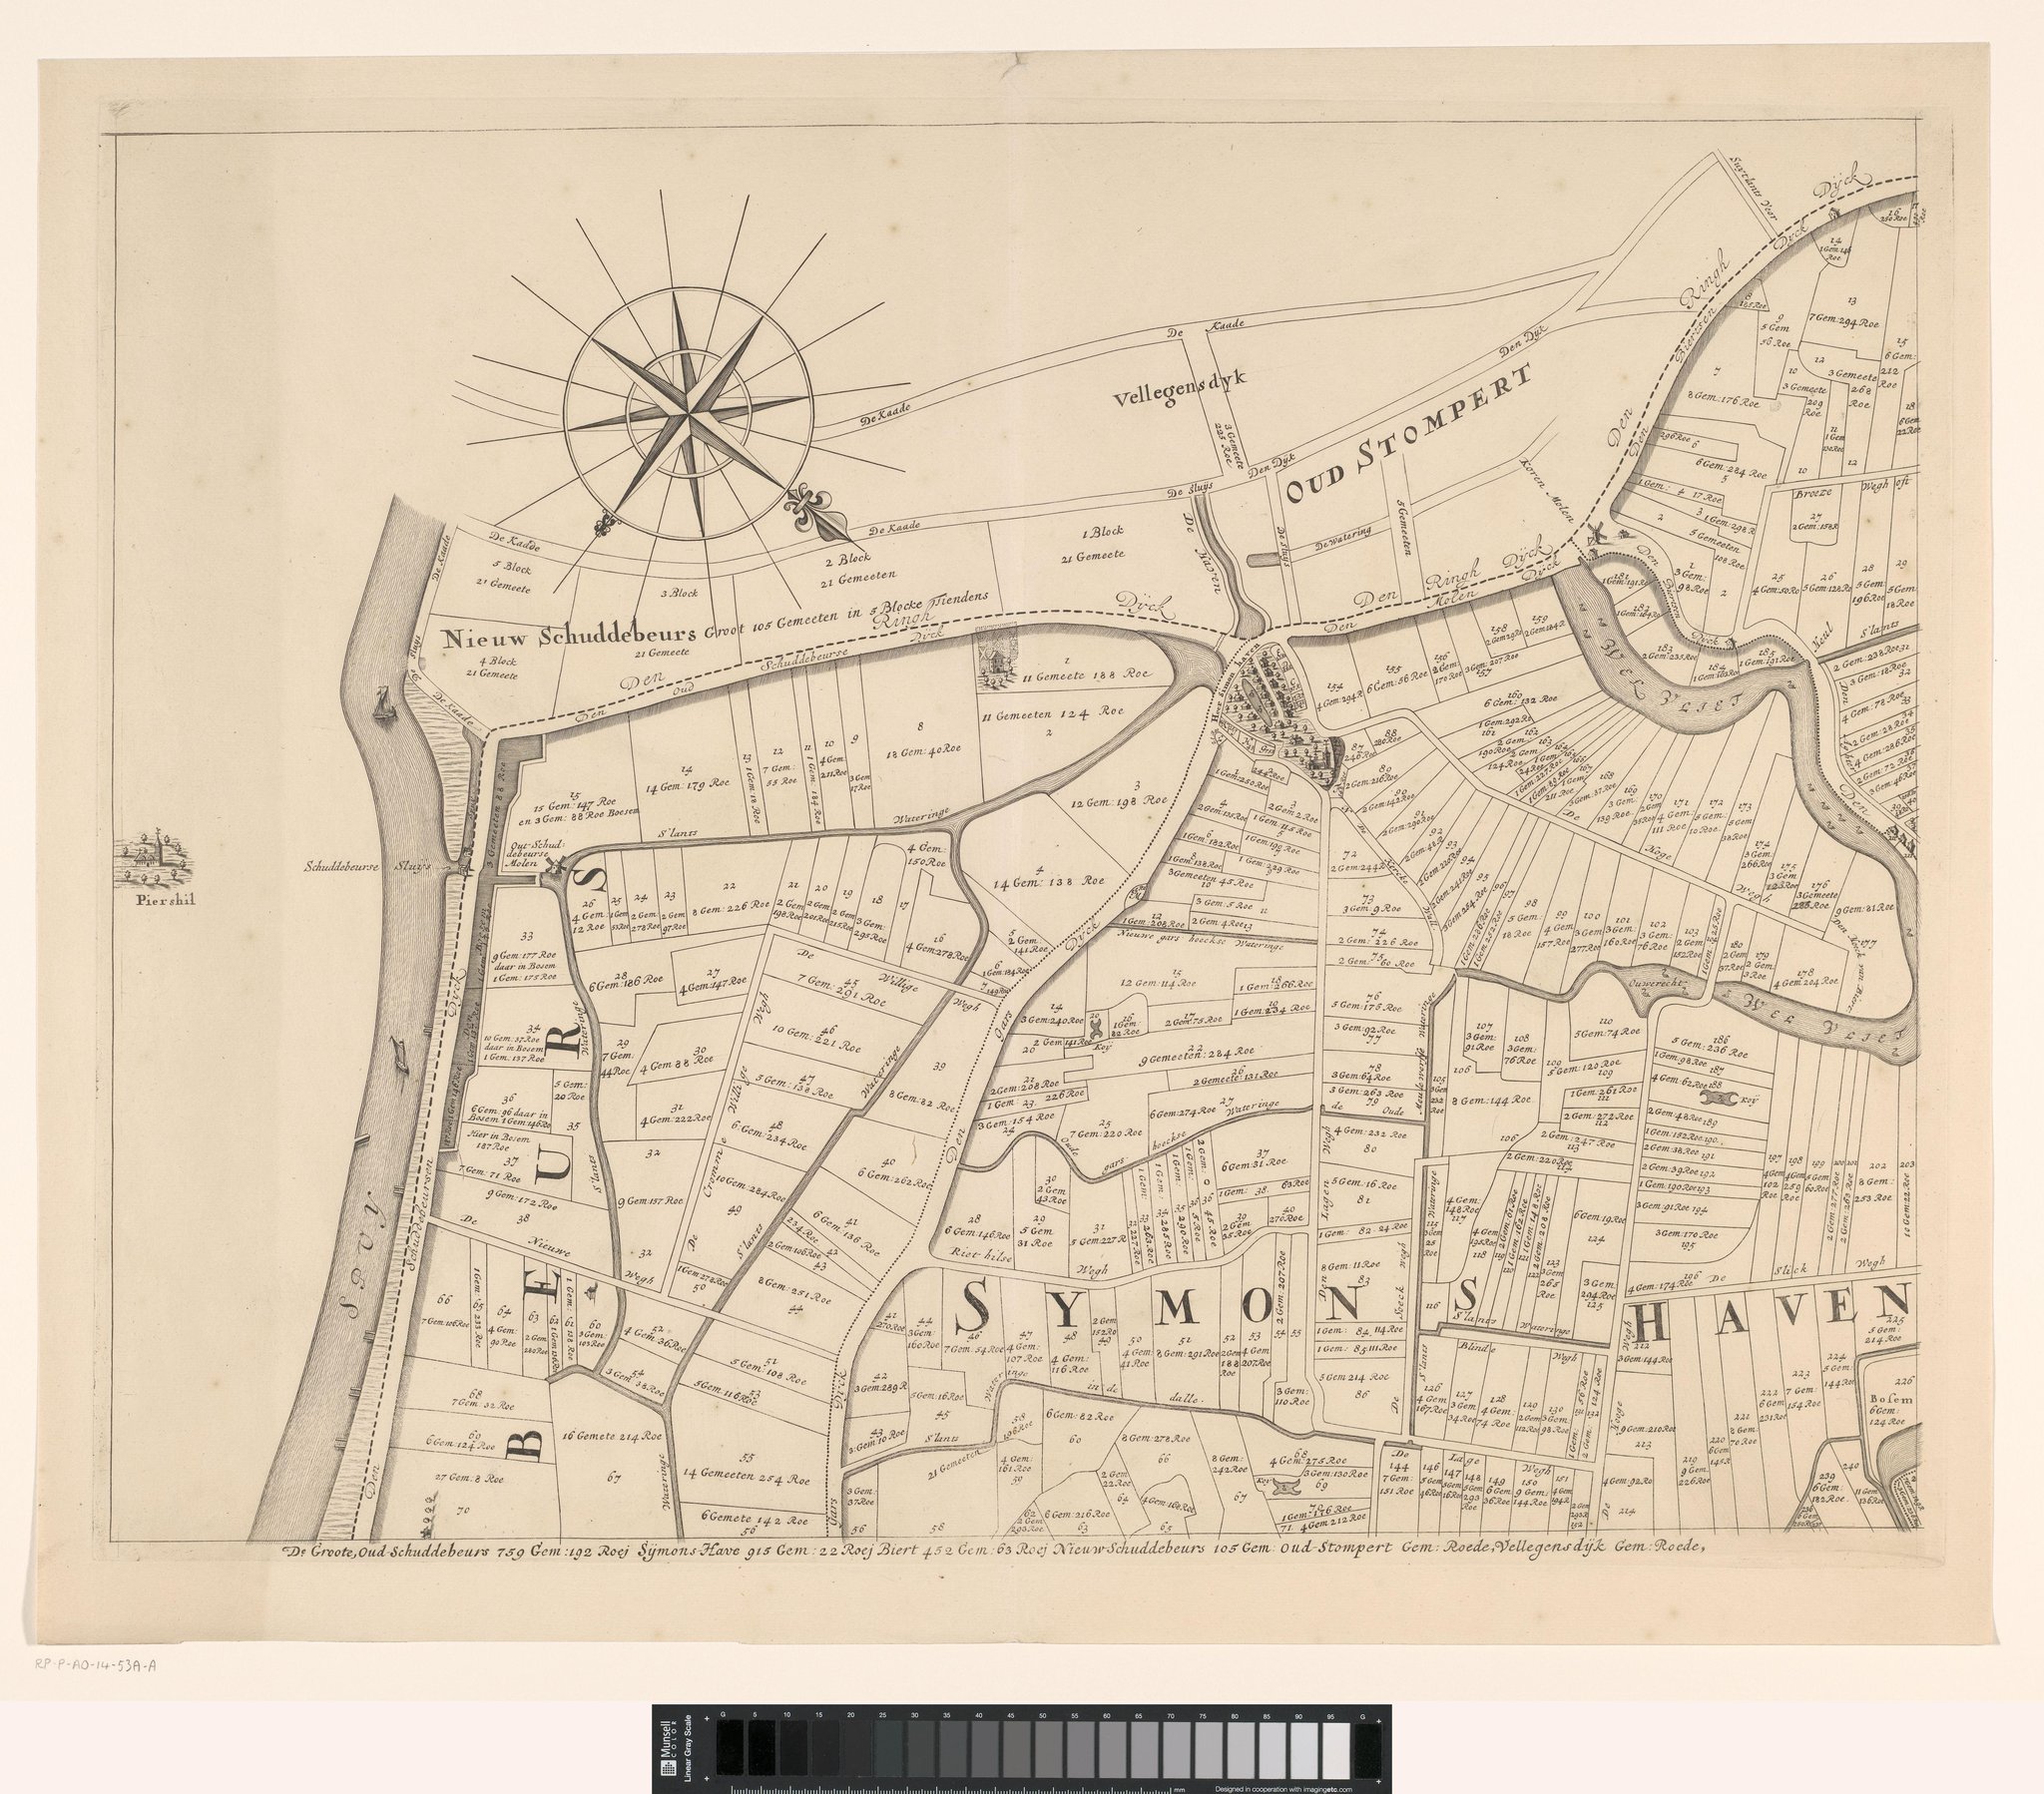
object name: print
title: Kaart van de Ring van Putten (deel linksboven)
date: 1701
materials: paper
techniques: engraving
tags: maps of separate countries or regions, polder, reclaimed land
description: Voor zover bekend is de kaart waar deze prent deel van is drie keer gedrukt; in 1701, 1738 en 1774. De huidige prent is onderdeel van de tweede druk. Waarschijnlijk verscheen de eerste druk (1701) zonder wapens van de opperdijkgraaf, secretaris en hoogheemraden. Zie RP-P-AO-14-53 voor een exemplaar van de eerste druk/staat. Voor de tweede druk (1738) werden de vier platen van de kaart bijgewerkt waardoor van elke plaat een tweede staat ontstond. Ook werd langs de bovenkant een wapenrand (gedrukt van één plaat) en langs de zijkanten een sierrand (gedrukt van twee platen) toegevoegd. Het bestuur bestond destijds uit opperdijkgraaf Gualterus de Raet, secretaris Nicolaas Hooreman en hoogheemraden Dirck Lieve, Cornelis Taal, Adriaen Roosmael, Pieter van der Mersch en Johannes Assuerus Roosendael. Voor de derde druk (1774) werd in ieder geval de plaat rechtsonder bijgewerkt. Verder onderzoek is nodig om vast te stellen of de drie andere platen van de kaart ook werden bijgewerkt. Het bestuur bestond destijds uit opperdijkgraaf Dirk Bouwens, secretaris Carel Willem Hogerwaard en hoogheemraden Joh. van der Zaag, Hendrik Hoogendyck, Jan Jacob Villerius, Dammis Hoogendyck en Paulus Gevers.